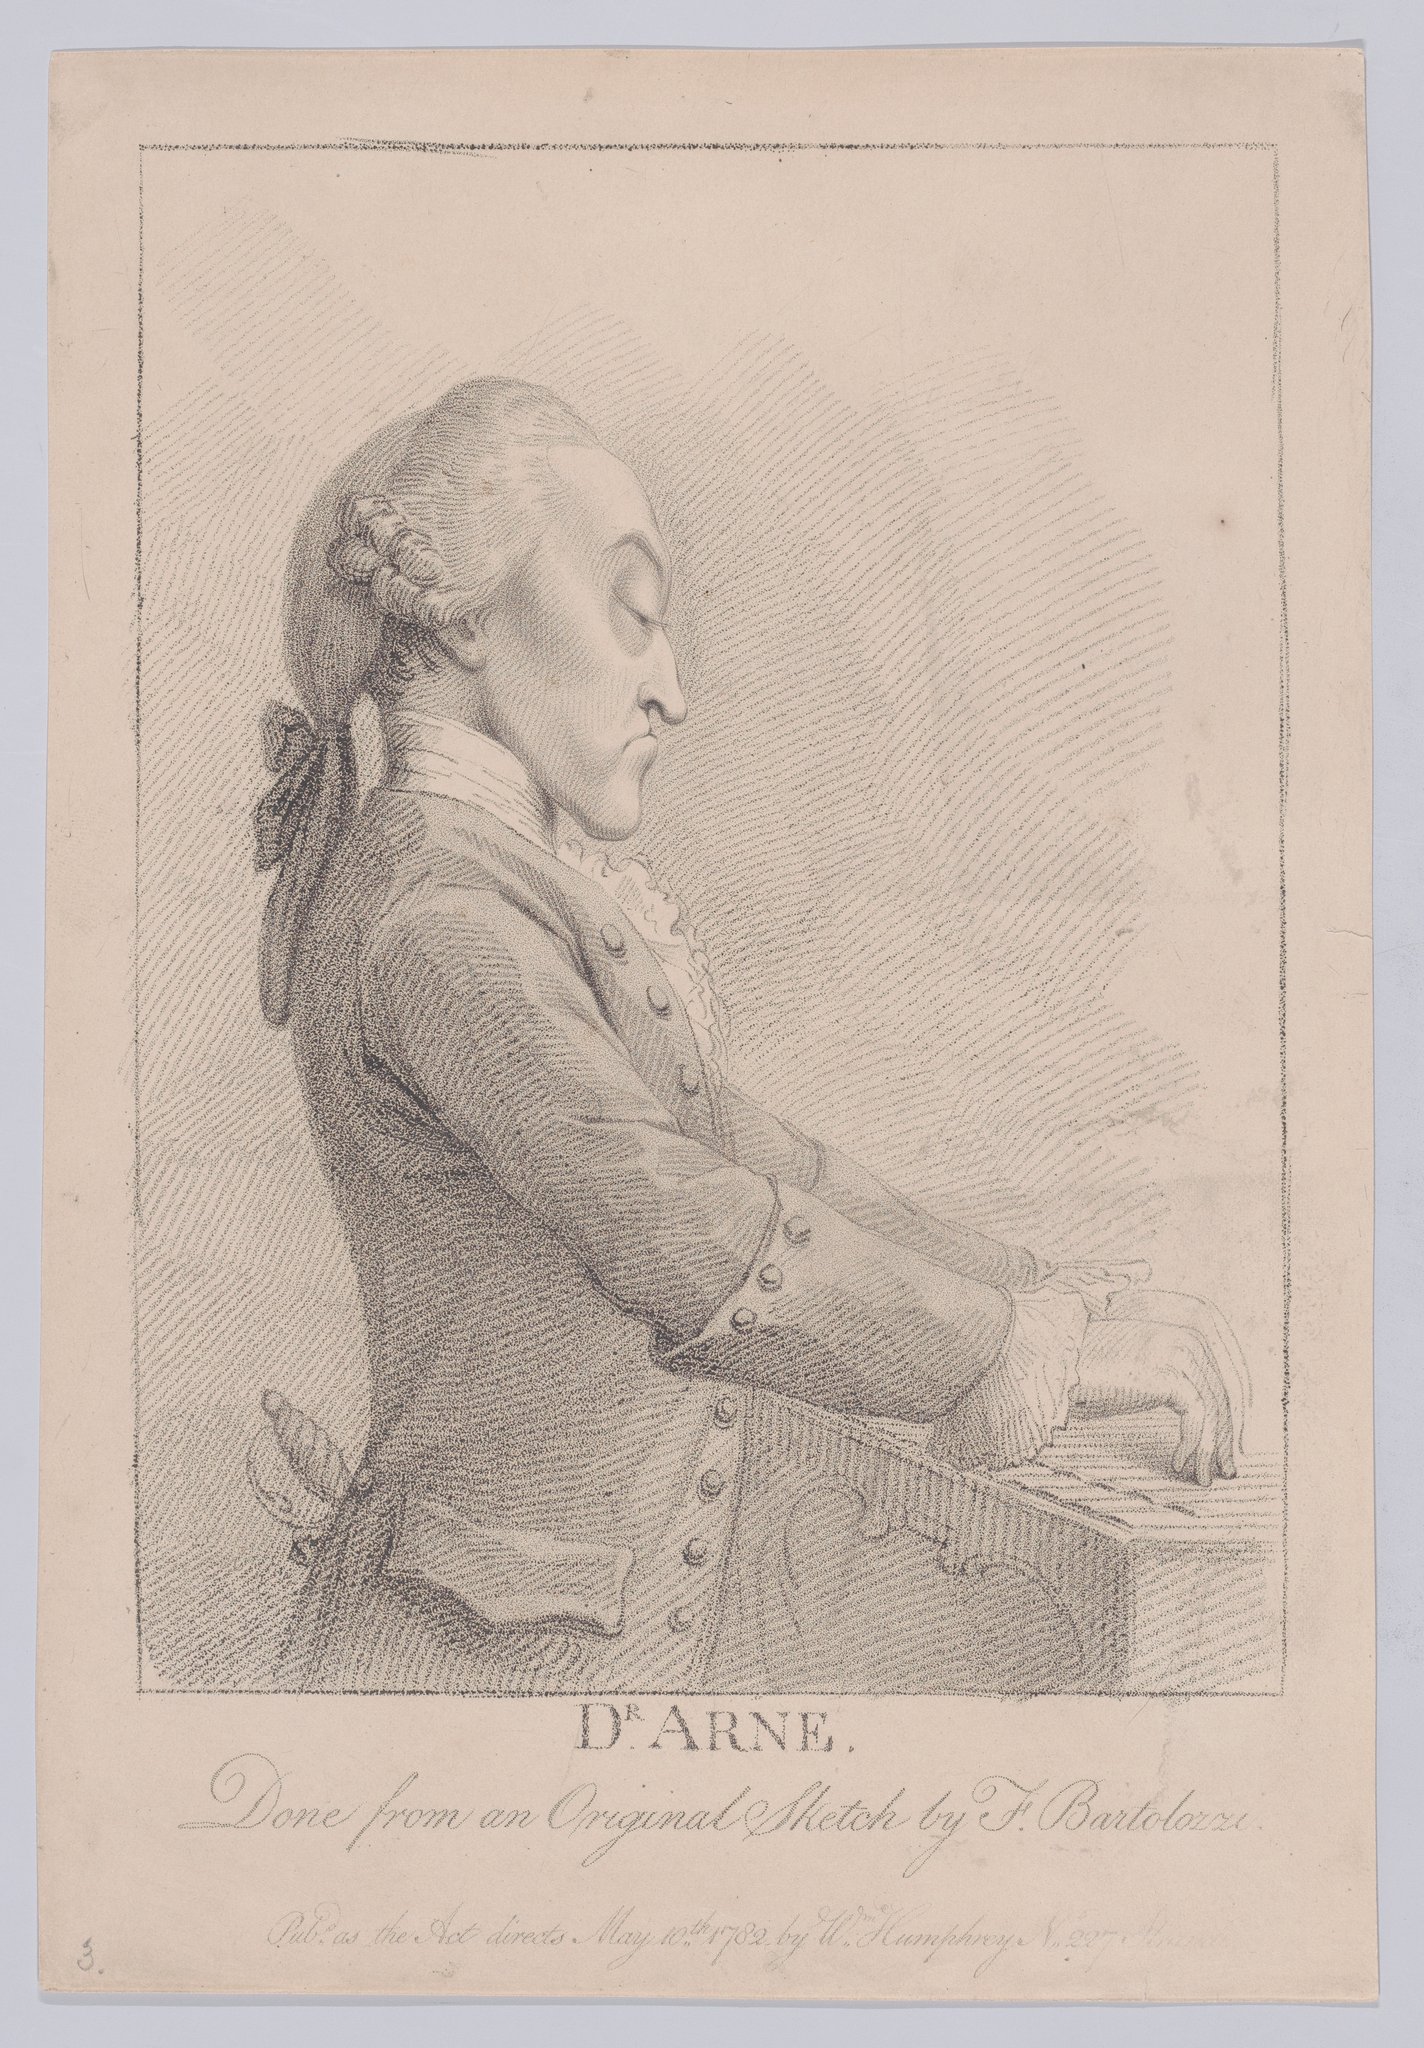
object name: print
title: Dr. Arne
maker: francesco bartolozzi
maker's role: artist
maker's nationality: italian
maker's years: 1728-1815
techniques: printmaking, etching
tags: men,caricature